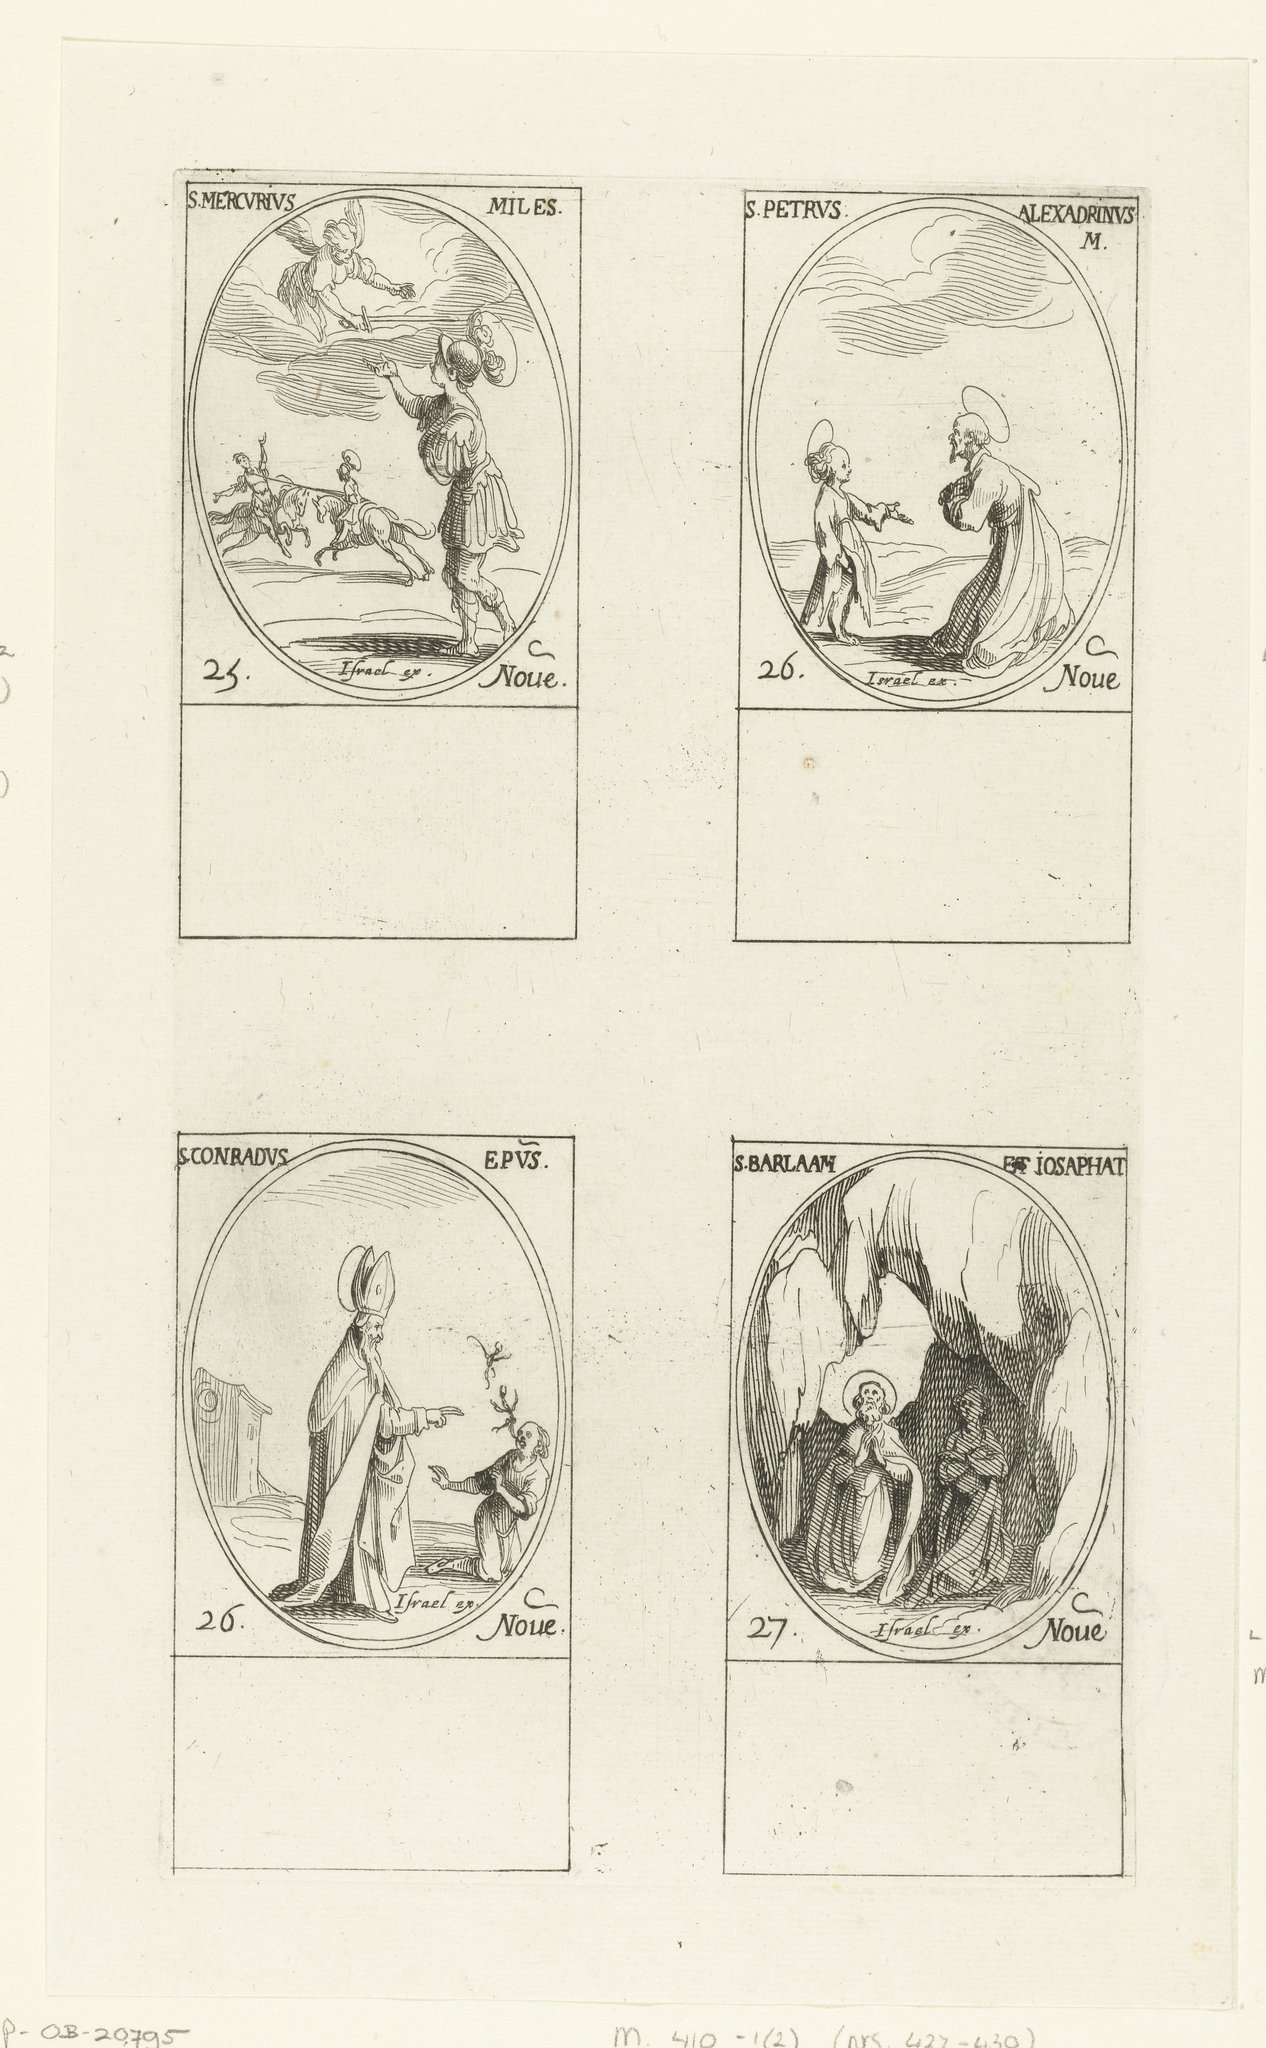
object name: print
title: Heilige Mercurius van Cappadocië, Heilige Petrus van Alexandrië, Heilige Conradus van Konstanz, Heilige Barlaam en Heilige Josaphat van Indië (25-27 november)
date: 1632-1636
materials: paper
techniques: etching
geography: paris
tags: the conversion of the young prince josaphat by the hermit barlaam, male saints (with name)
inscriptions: collector's mark: Lugt 240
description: Blad met vier ovale voorstellingen, elk met opschrift en datum in het Latijn: linksboven de Heilige Mercurius van Cappadocië geeft zijn zwaard aan (of krijgt het van?) een engel in de hemel, rechtsboven de Heilige Petrus van Alexandrië geknield voor een kind, linksonder de Heilige Conradus van Konstanz die duivels uitdrijft bij een vrouw, rechtsonder de Heilige Barlaam en de Heilige Josaphat van Indië geknield naast elkaar in een grot. Deze prent is onderdeel van een serie prenten met voorstellingen van de heiligen en de christelijke feestdagen van het jaar. Er zijn steeds vier scènes van één plaat op één blad gedrukt. Inclusief bijbehorend titelblad en frontispice gaat het in totaal om 124 platen (490 voorstellingen). De drie platen met de laatste 12 scènes (de veranderlijke christelijke feestdagen) zijn in de derde staat versneden tot 12 kleine plaatjes, en met een apart titelblad uitgegeven.